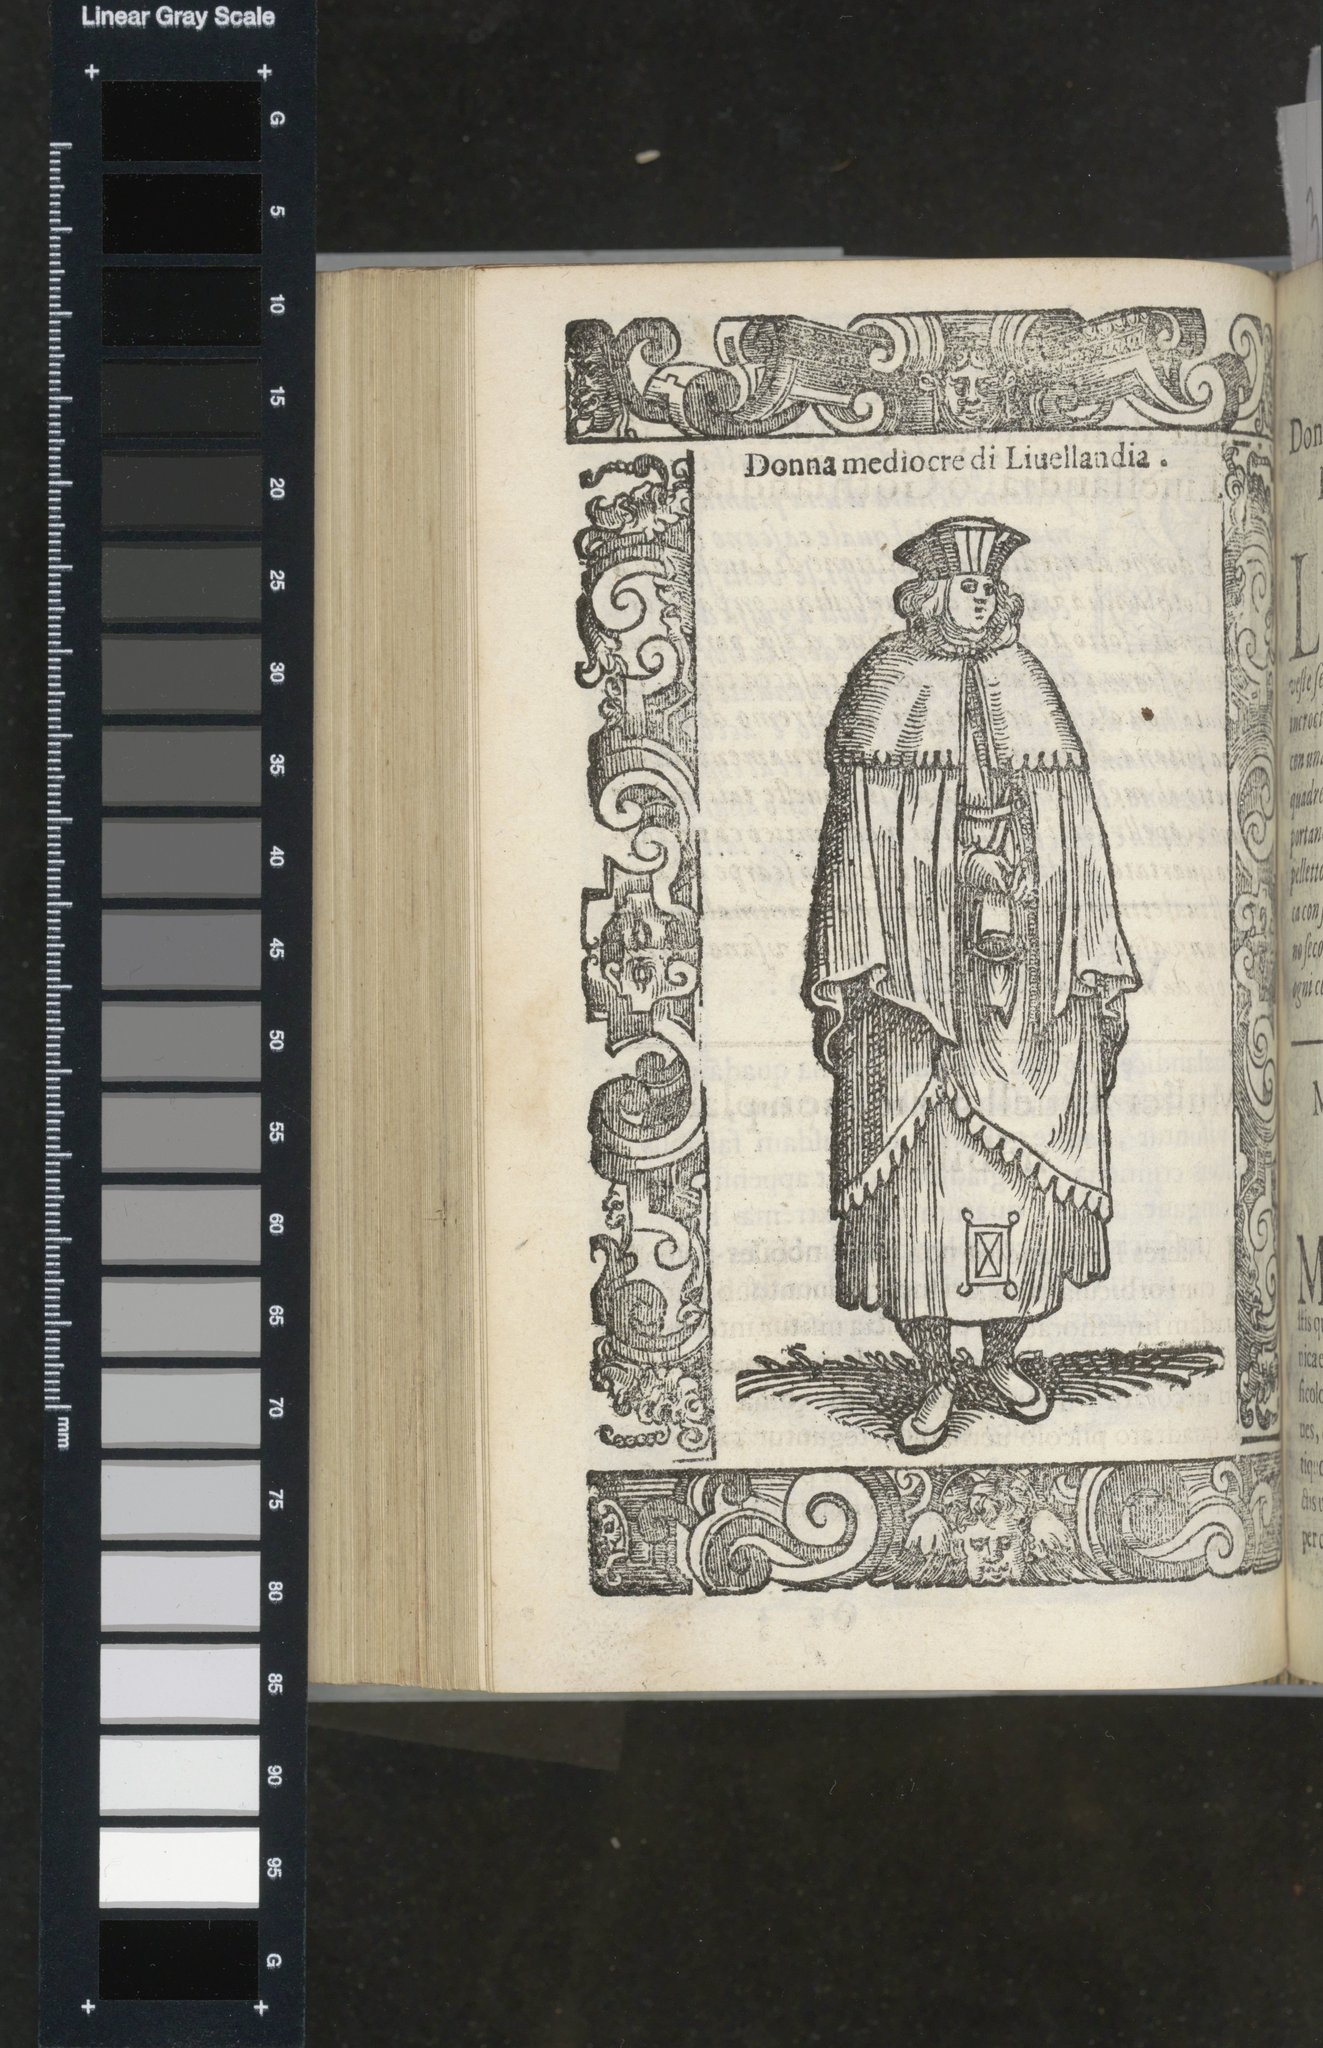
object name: costume print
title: Habiti antichi, et moderni di tutto il mondo...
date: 1598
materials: paper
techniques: woodcut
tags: fashion plates